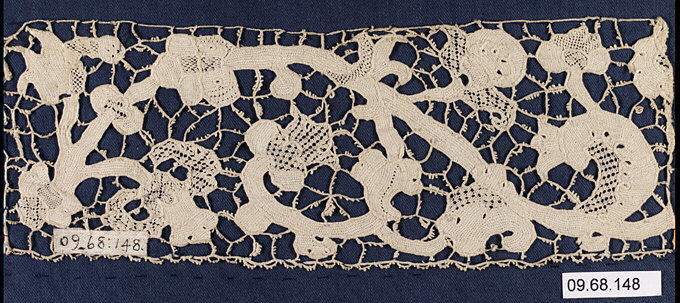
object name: fragment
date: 1601-1700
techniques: lace